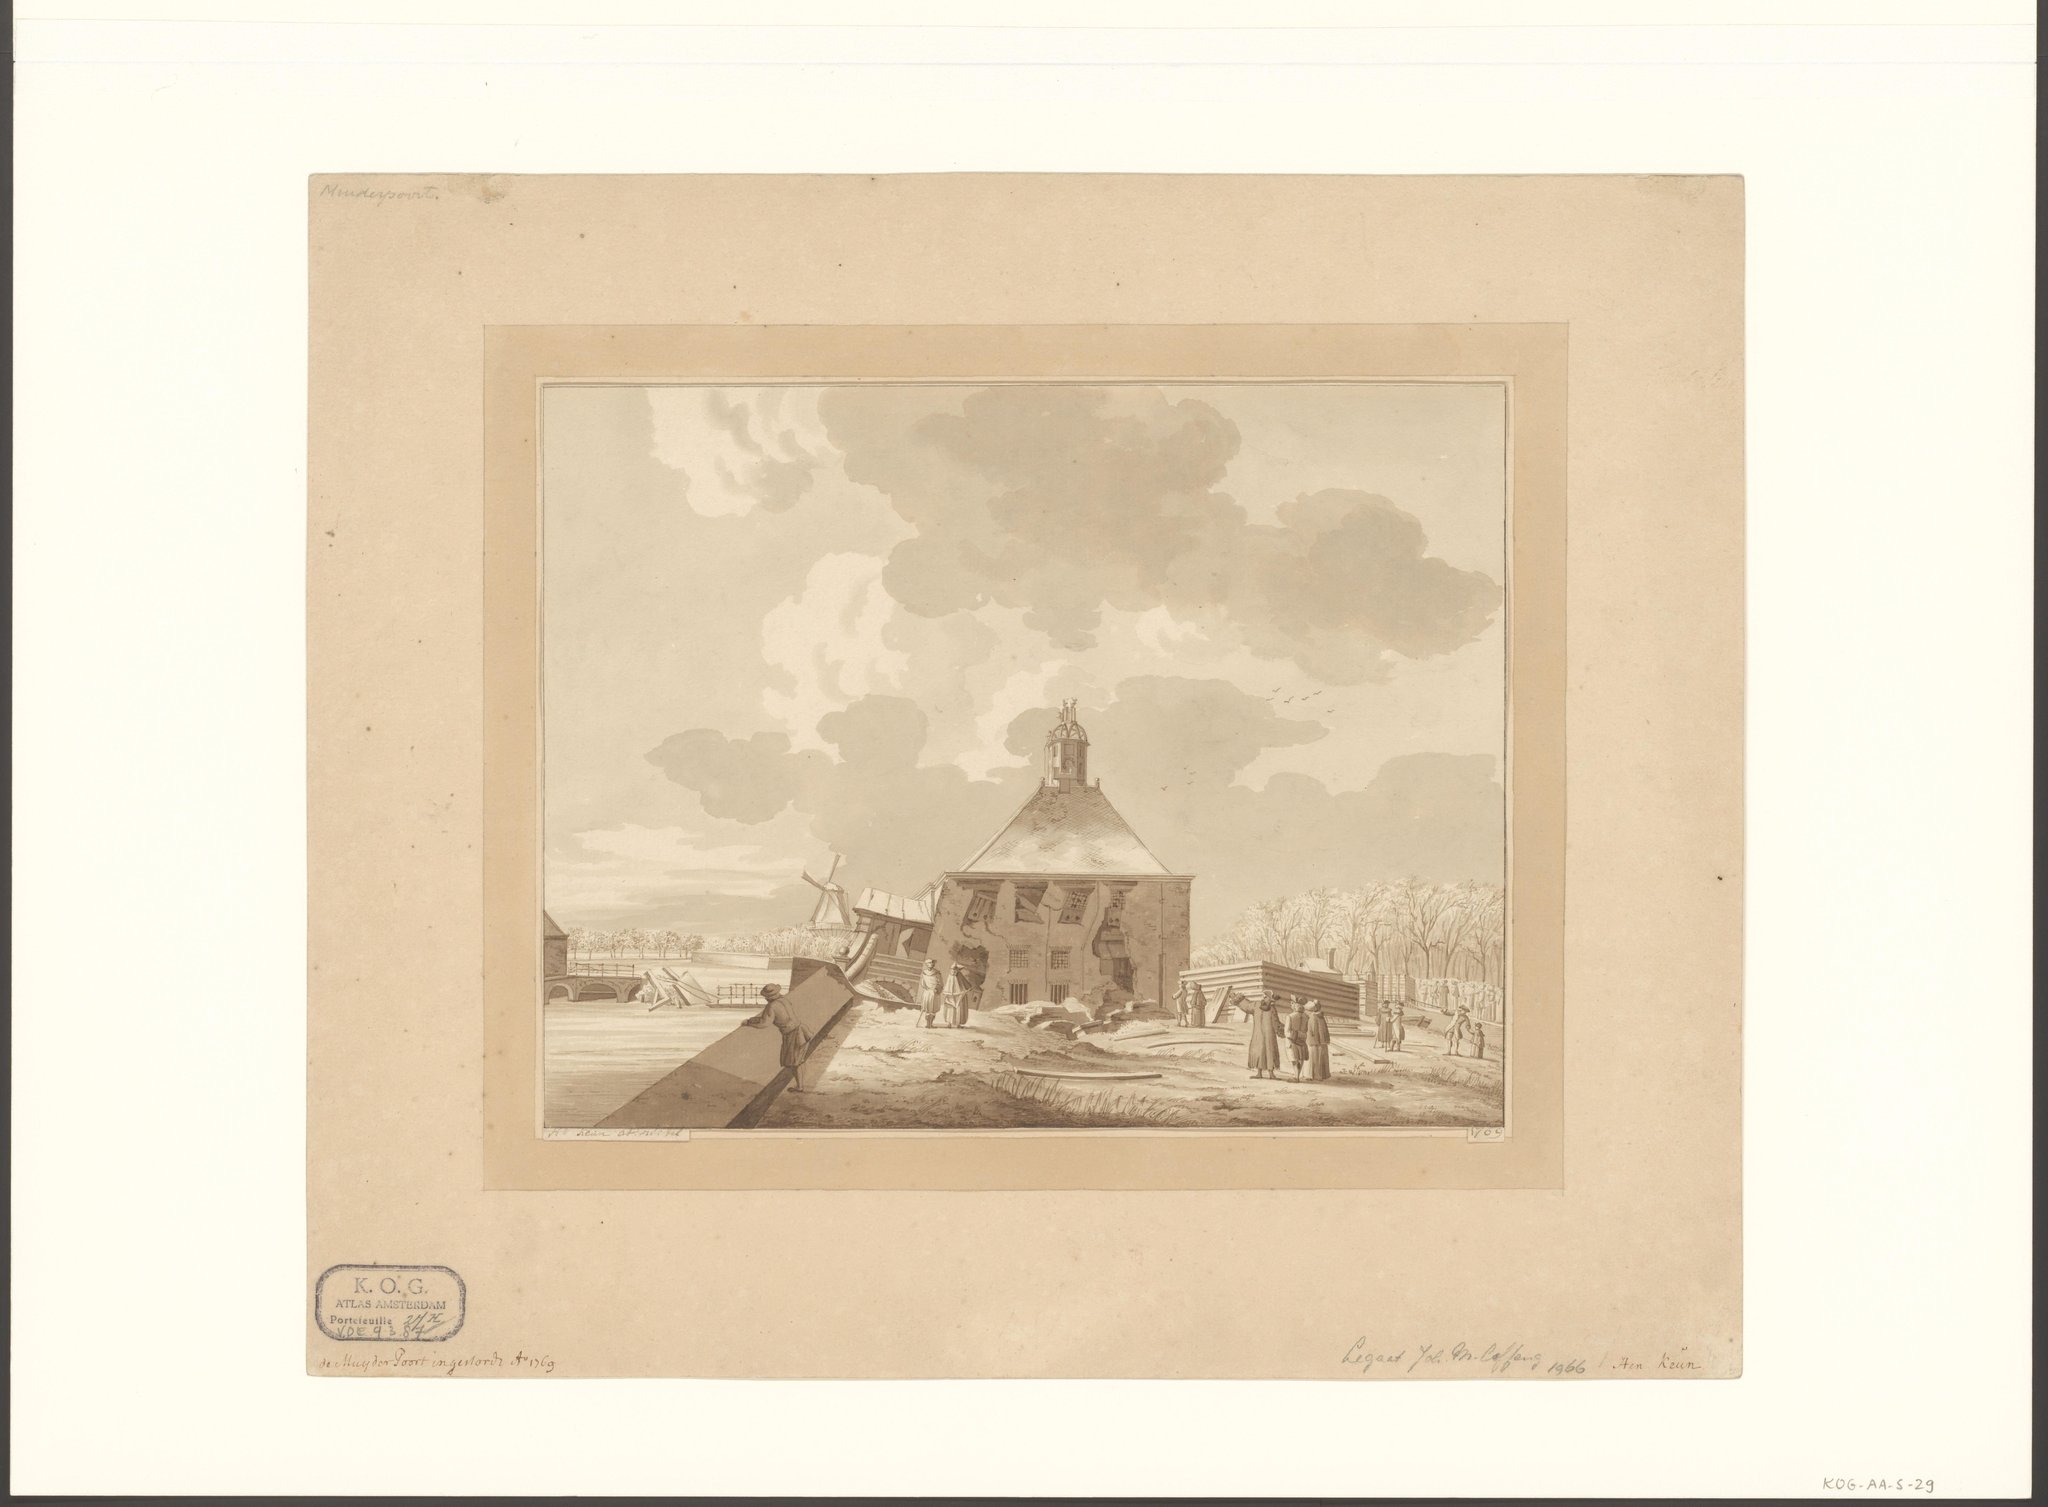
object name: drawing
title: Gezicht op de ingezakte Muiderpoort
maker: hendrik keun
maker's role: painter, print maker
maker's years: 1738-1787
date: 1769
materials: ink, paper, pencil, watercolor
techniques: brush, pen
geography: amsterdam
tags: assembly-room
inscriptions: number: ‘19’, collector's mark: ‘27 H / VDE 9.3.87’ Lugt 1641b, inscription: ‘2[...] H.C.V’, inscription: ‘Legaat Joh. M. Coffeng / 1966’, signature and date: ‘H. Keun ad: viv: del / 1769’, inscription: ‘de Muyder Poort ingestordt Ao 1769 / Hen. Keun’